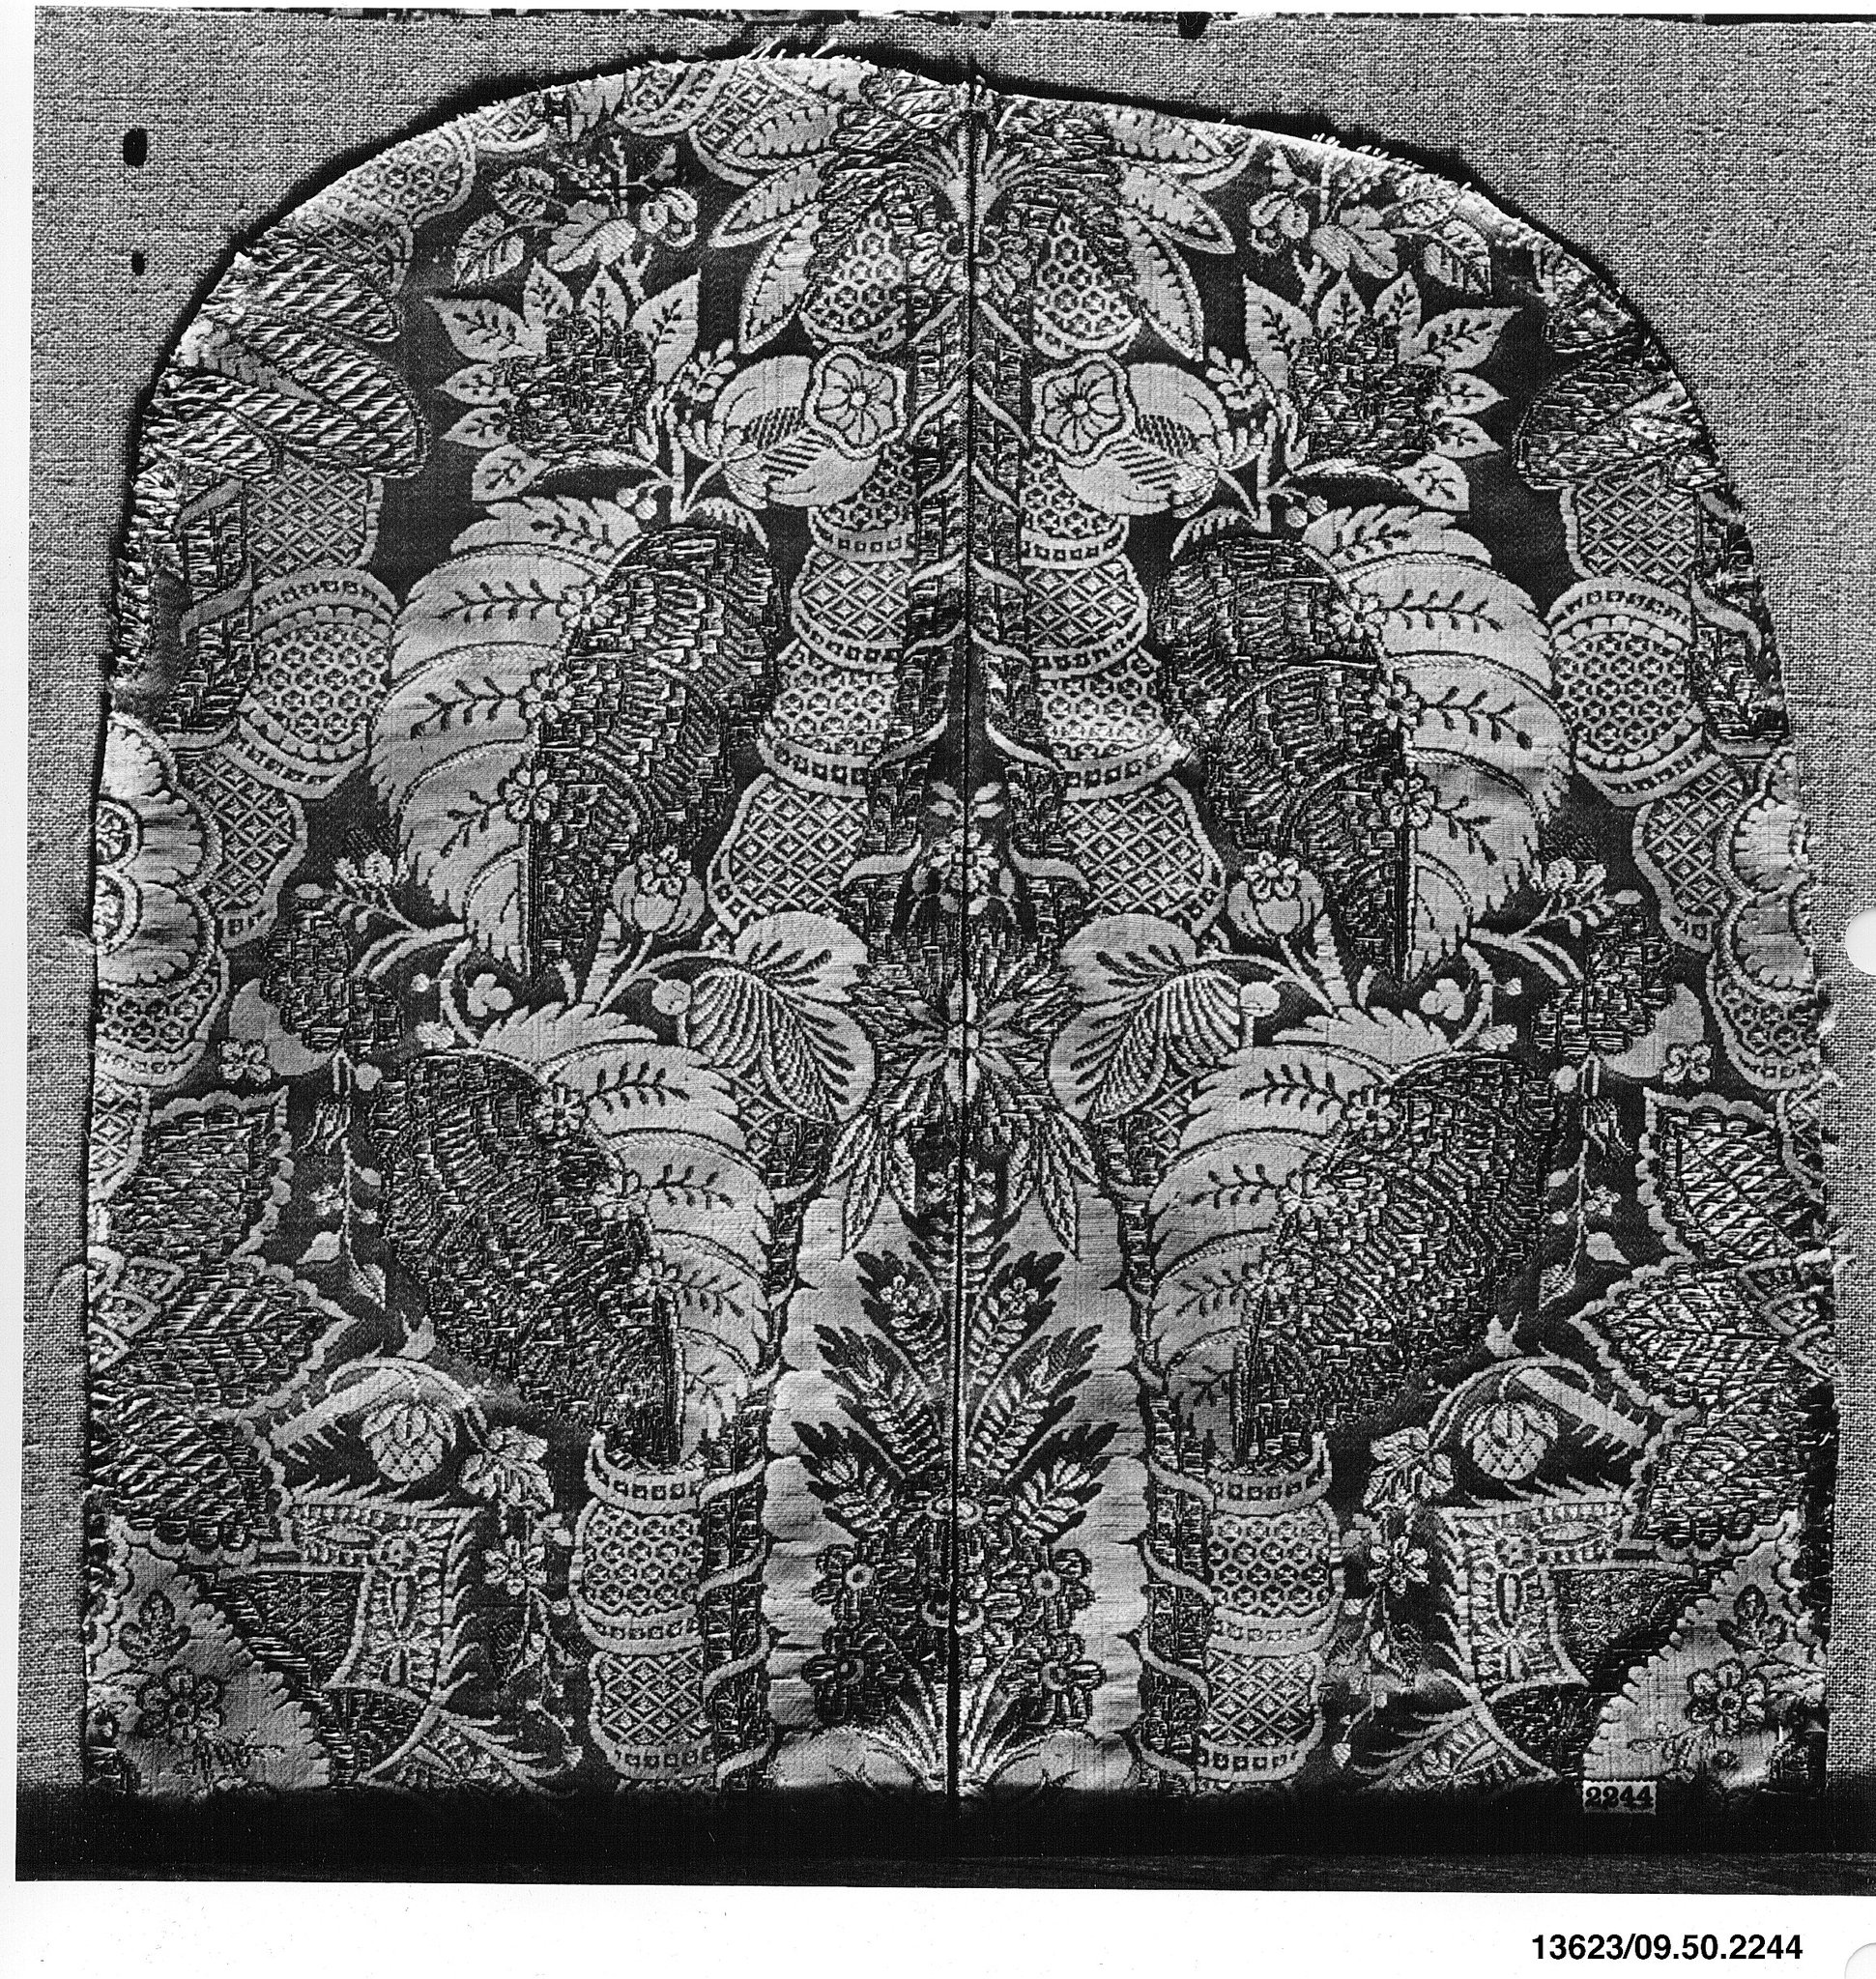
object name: piece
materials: silk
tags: leaves